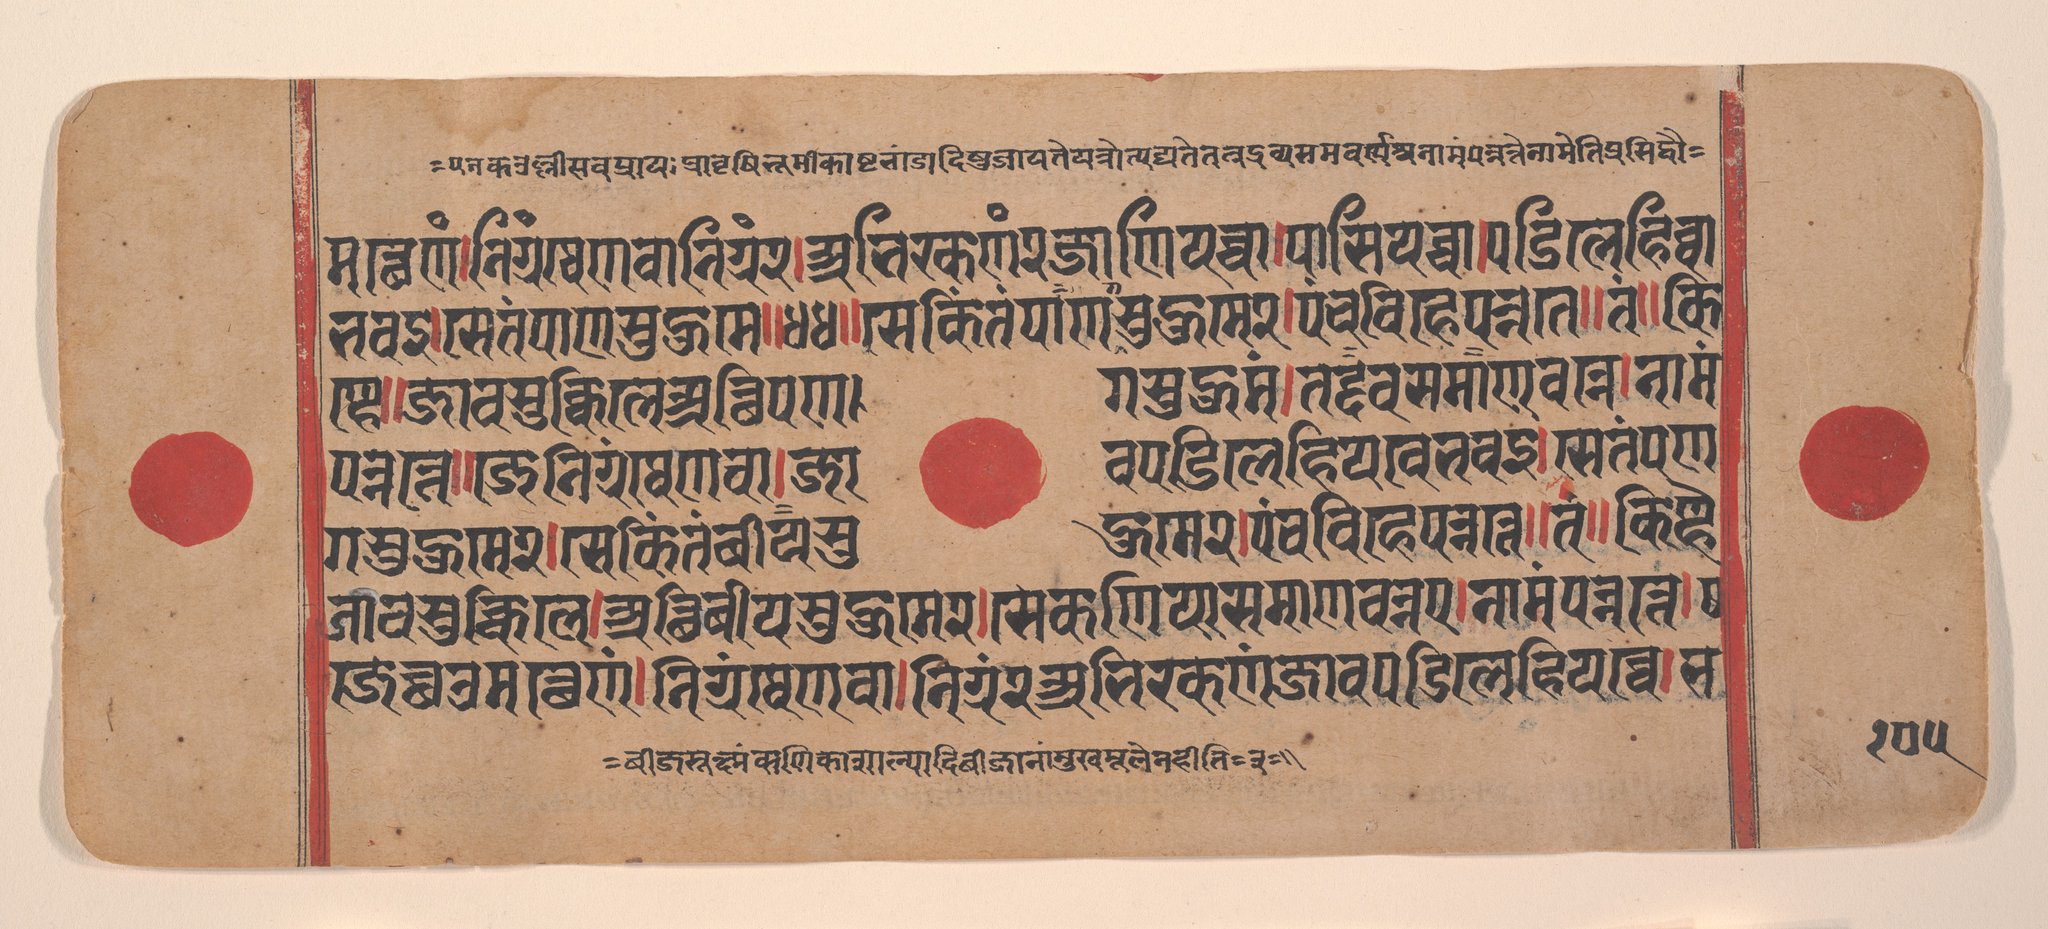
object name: folio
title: Page from a Dispersed Kalpa Sutra (Jain Book of Rituals)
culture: indian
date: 1401-1500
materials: gold, ink, paper, watercolor